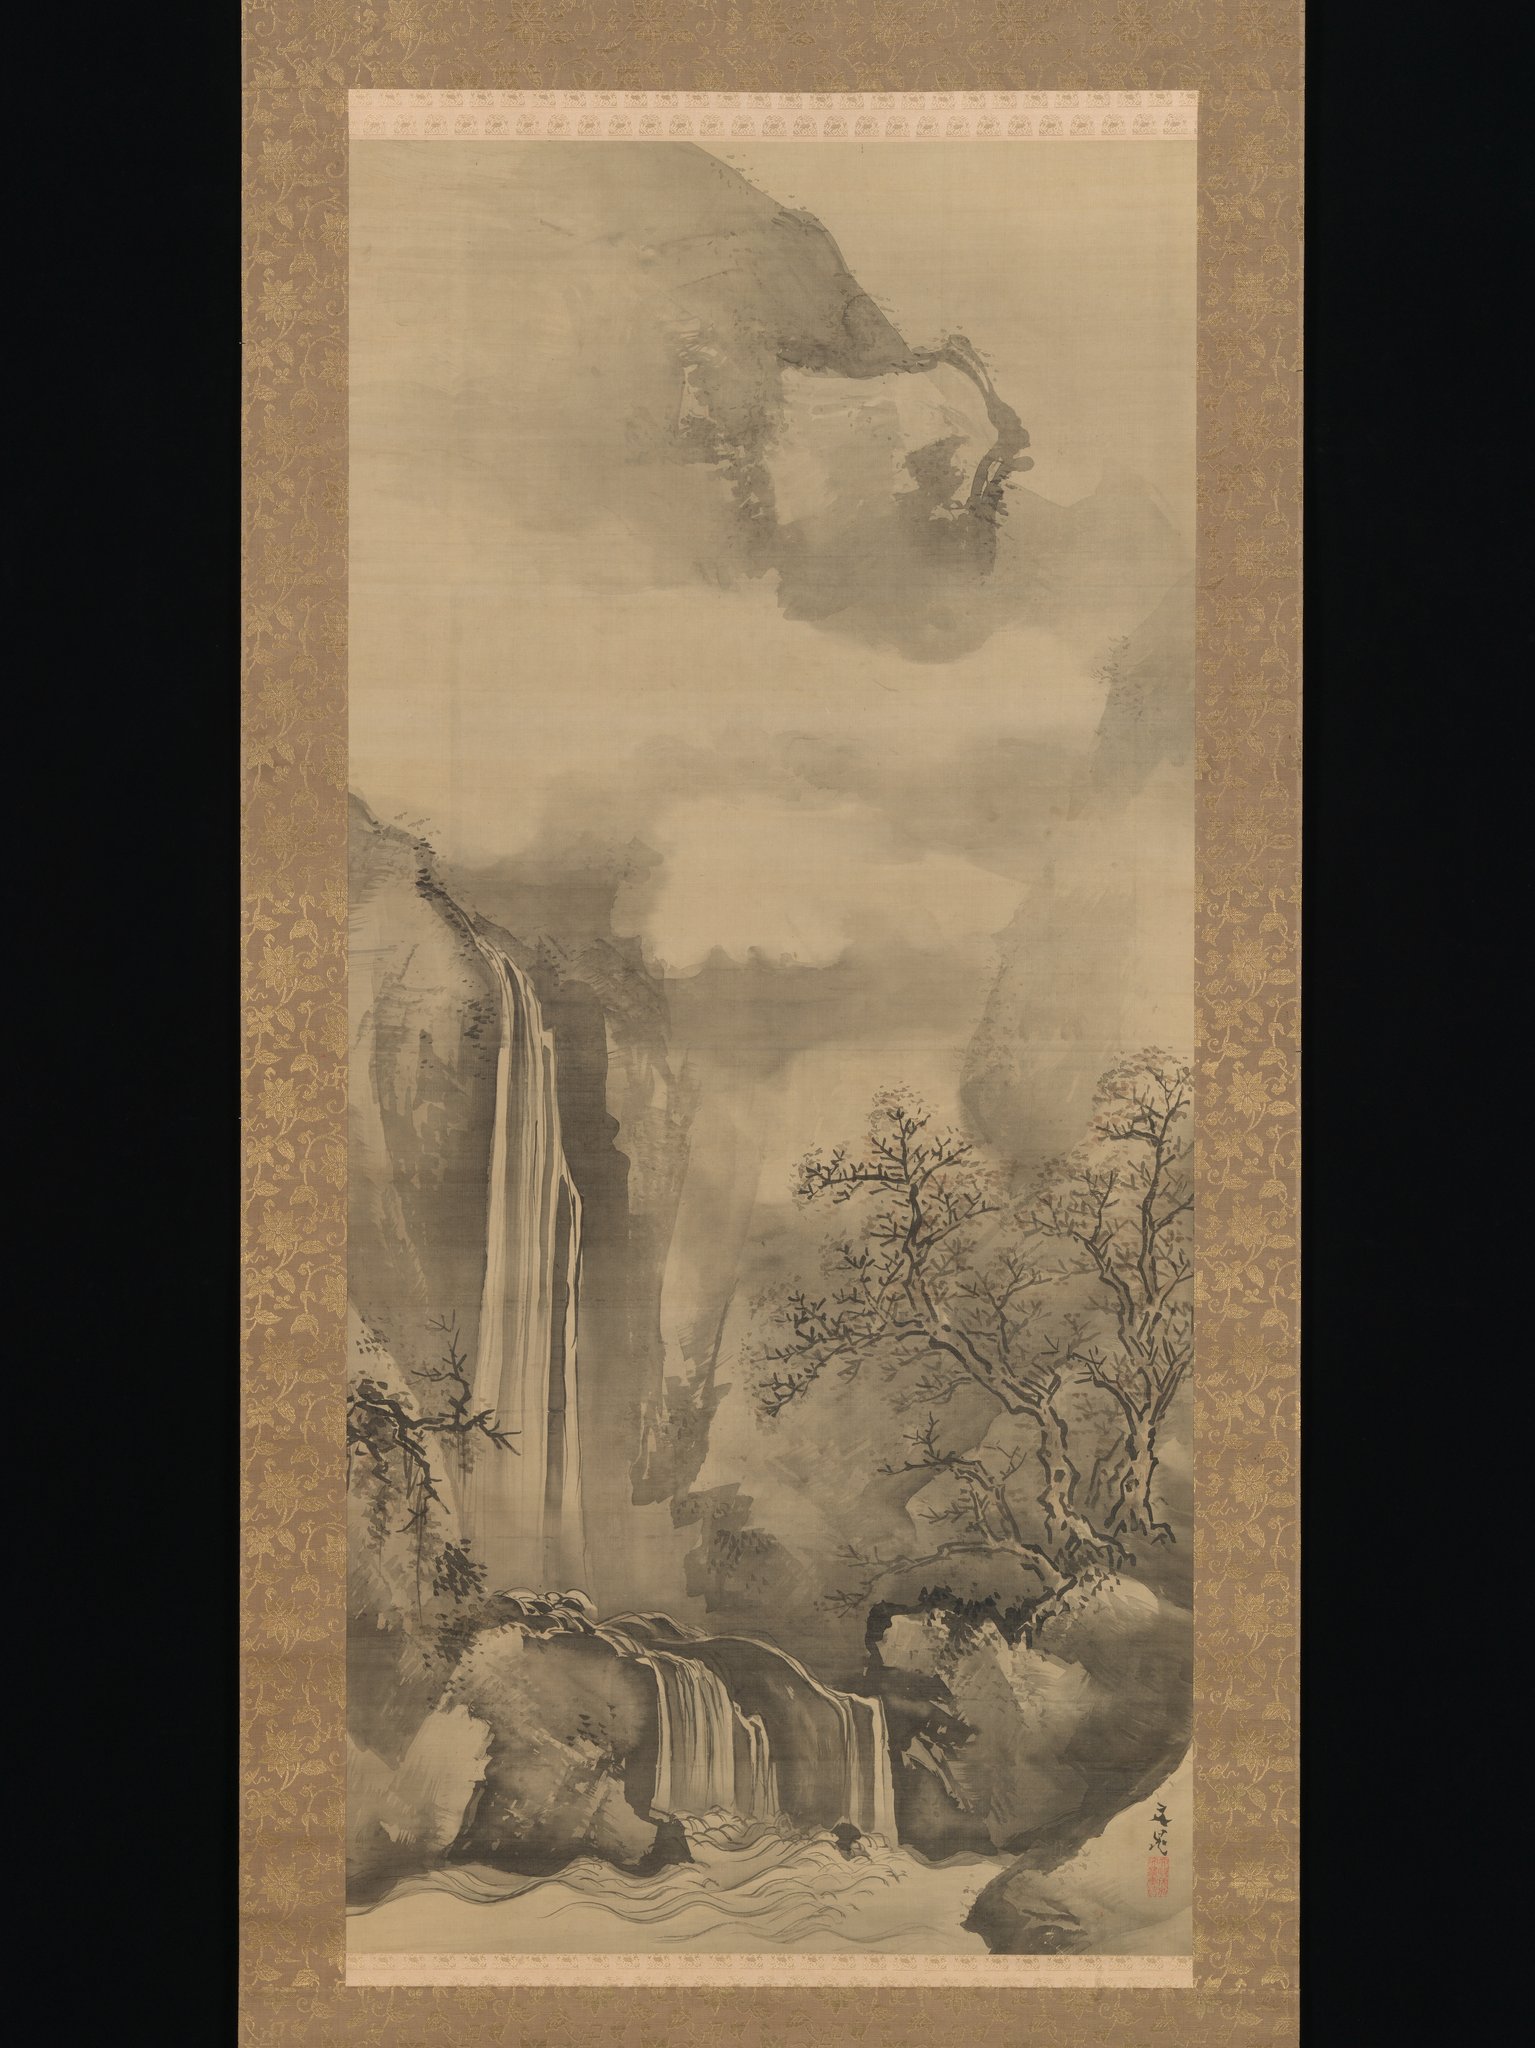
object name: hanging scroll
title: Landscape with Waterfall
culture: japanese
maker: tani bunchō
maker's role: artist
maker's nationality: japanese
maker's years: 1763-1840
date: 1828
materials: ink, silk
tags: waterfalls,mountains,landscapes